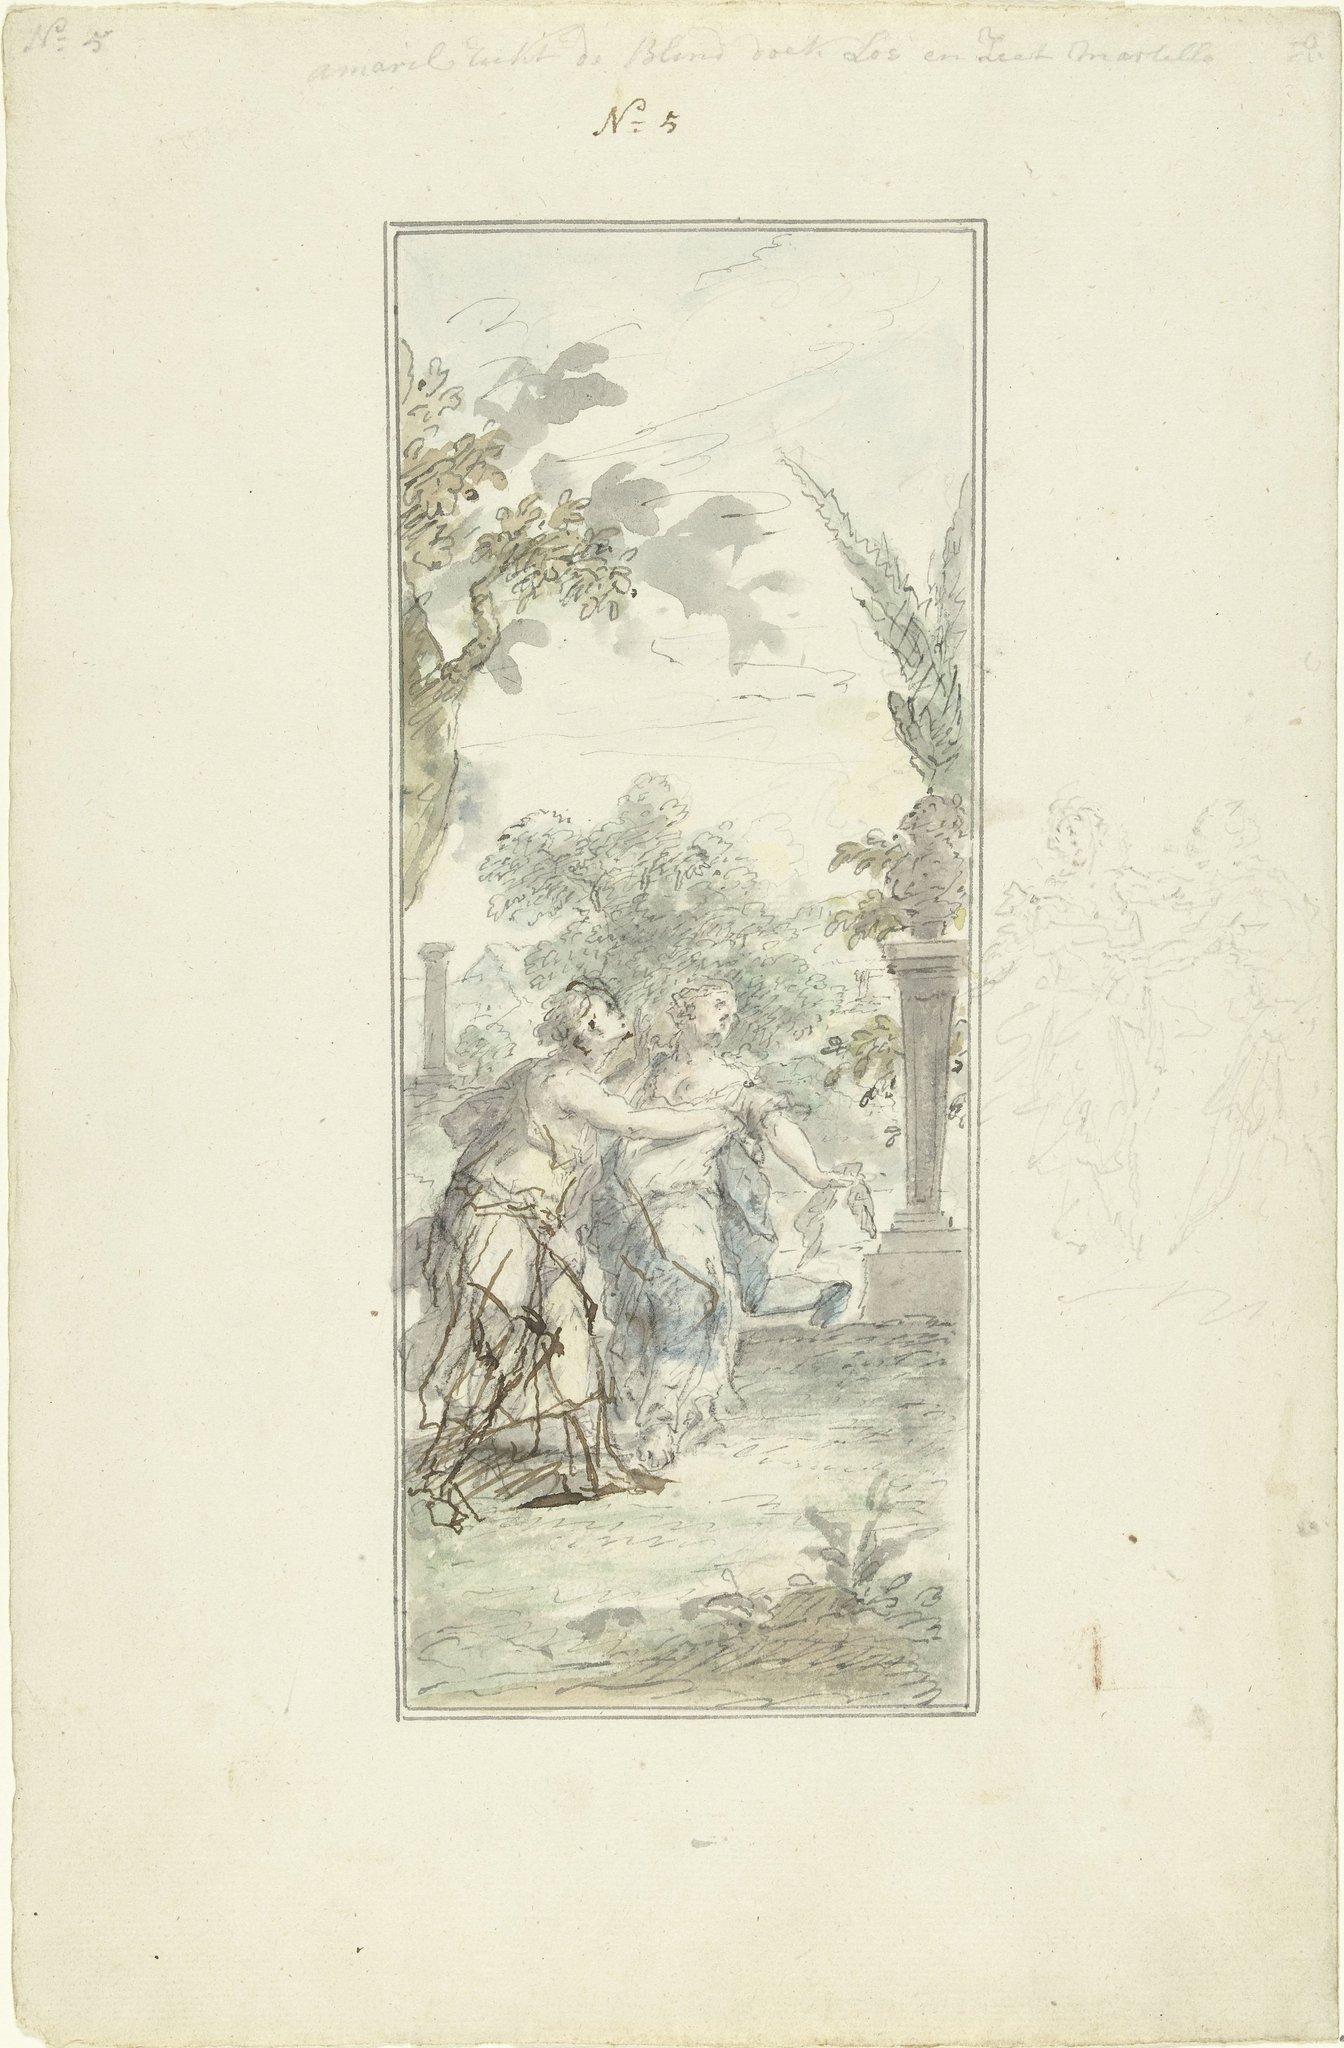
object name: watercolor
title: Ontwerp voor een zaalstuk: Amaryllis herkent Myrtillo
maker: dionys van nijmegen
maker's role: draughtsman, painter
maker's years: 1705-1798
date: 1715-1798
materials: ink, paper, pencil, watercolor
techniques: brush, pen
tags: (scenes from) specific works of literature: guarini, pastor fido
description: Scène uit 'Il Pastor Fido' van Guarini. Ontwerp voor een schildering.